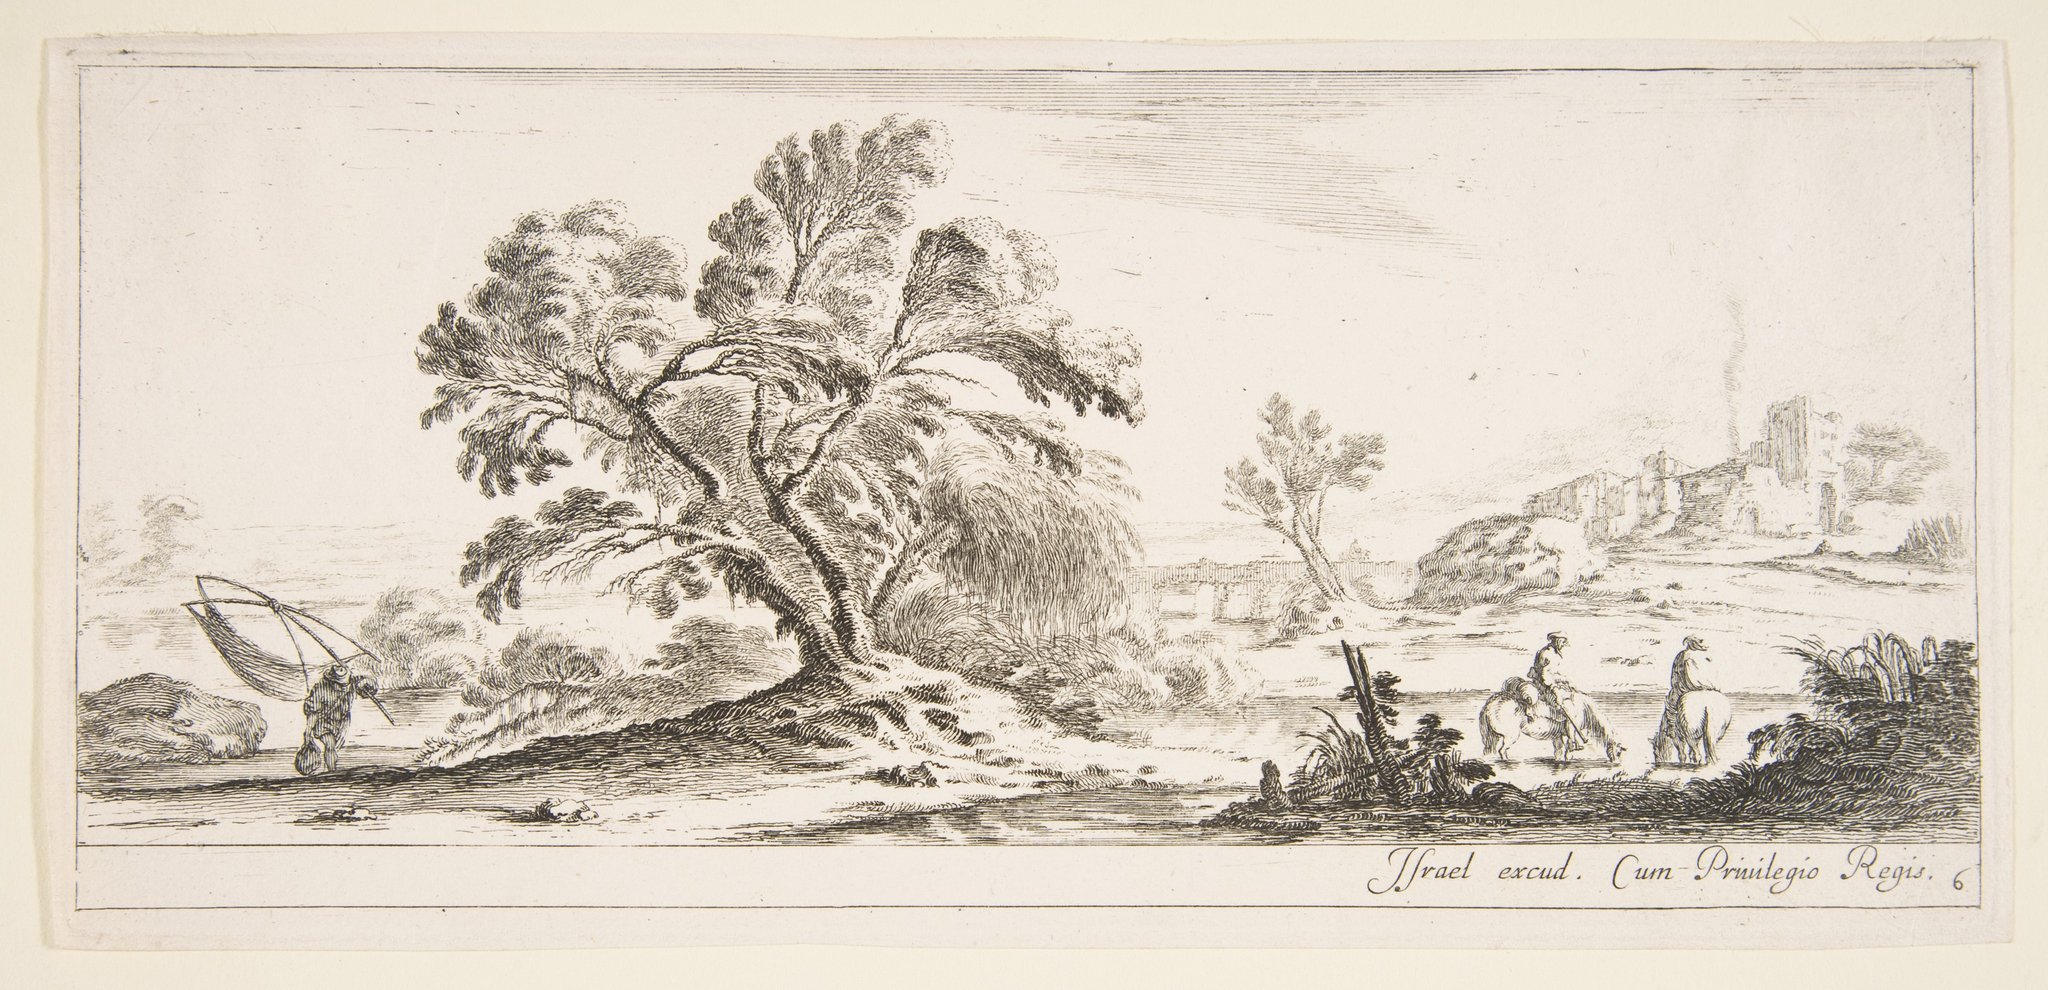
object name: print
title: Plate 6: a fisherman carrying a net to left, two horsemen in a stream to right, a tree in center, a castle in ruins to right in the background, from 'Various landscapes' (Divers paysages)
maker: stefano della bella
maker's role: artist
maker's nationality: italian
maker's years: 1610-1664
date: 1641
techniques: etching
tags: men,horses,trees